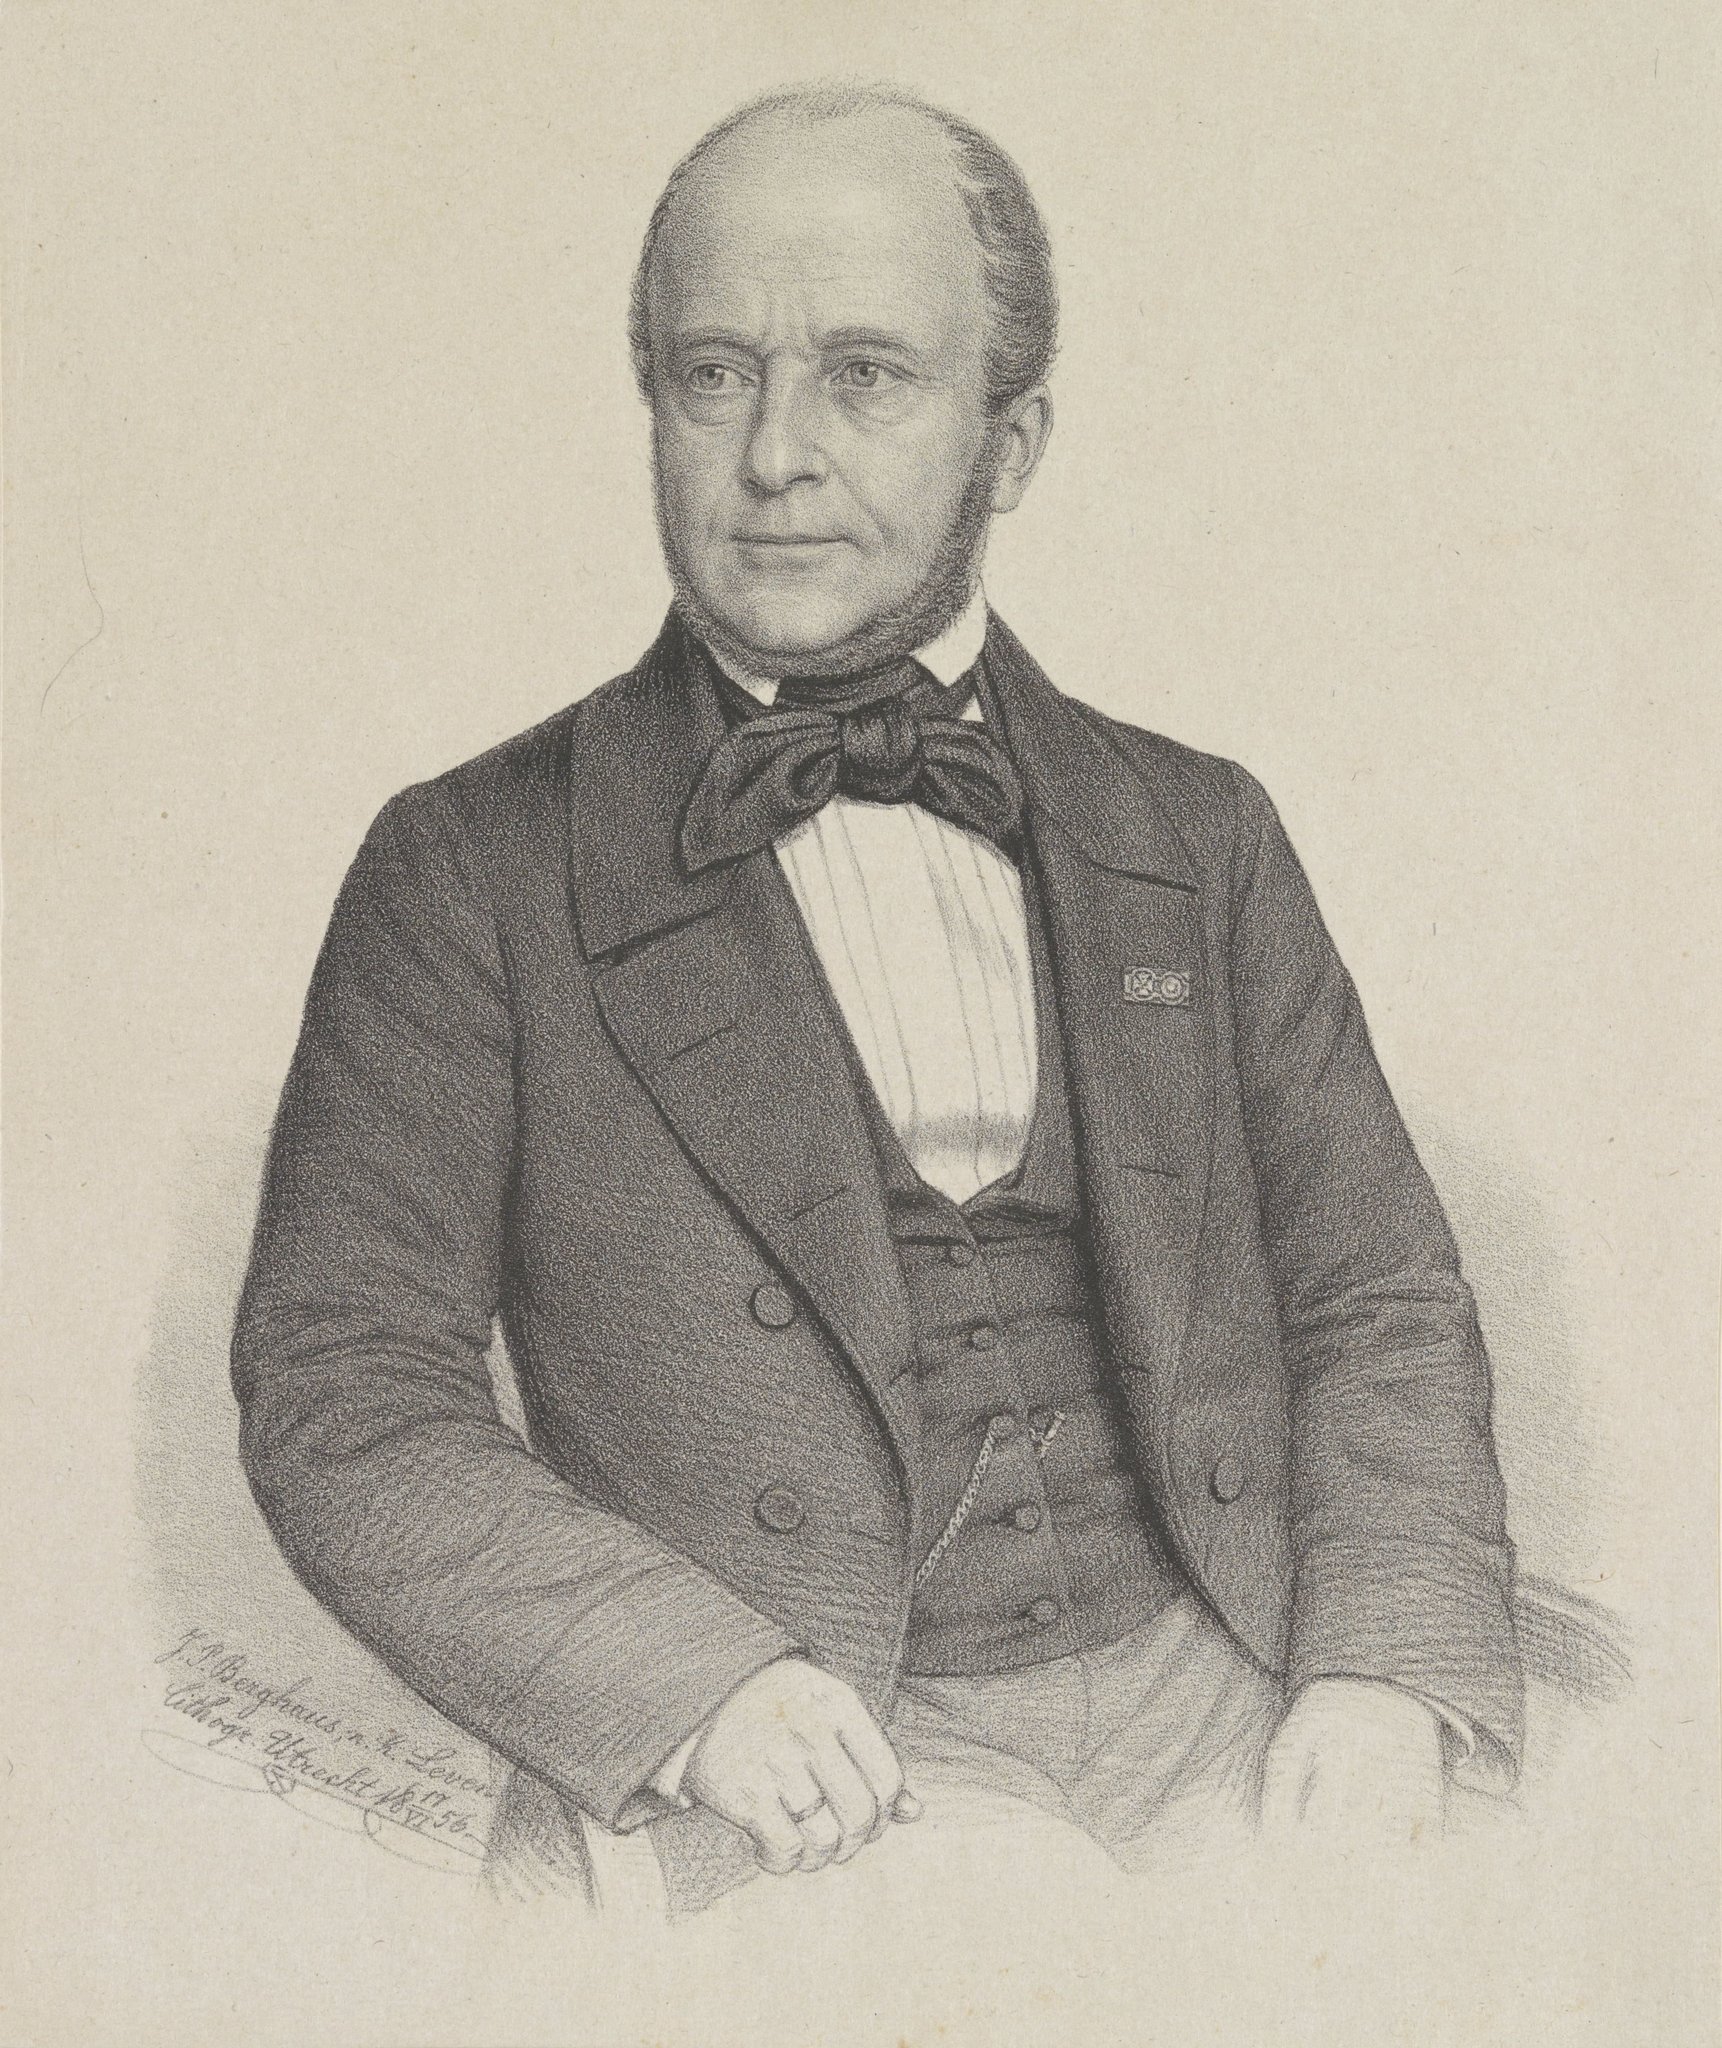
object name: print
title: Portret van een onbekende man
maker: johann peter berghaus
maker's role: print maker, printer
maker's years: 1810-1870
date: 1856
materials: paper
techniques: lithograph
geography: utrecht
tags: historical persons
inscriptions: collector's mark: Lugt 2228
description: De geportretteerde draagt een das en een ketting aan zijn vest.